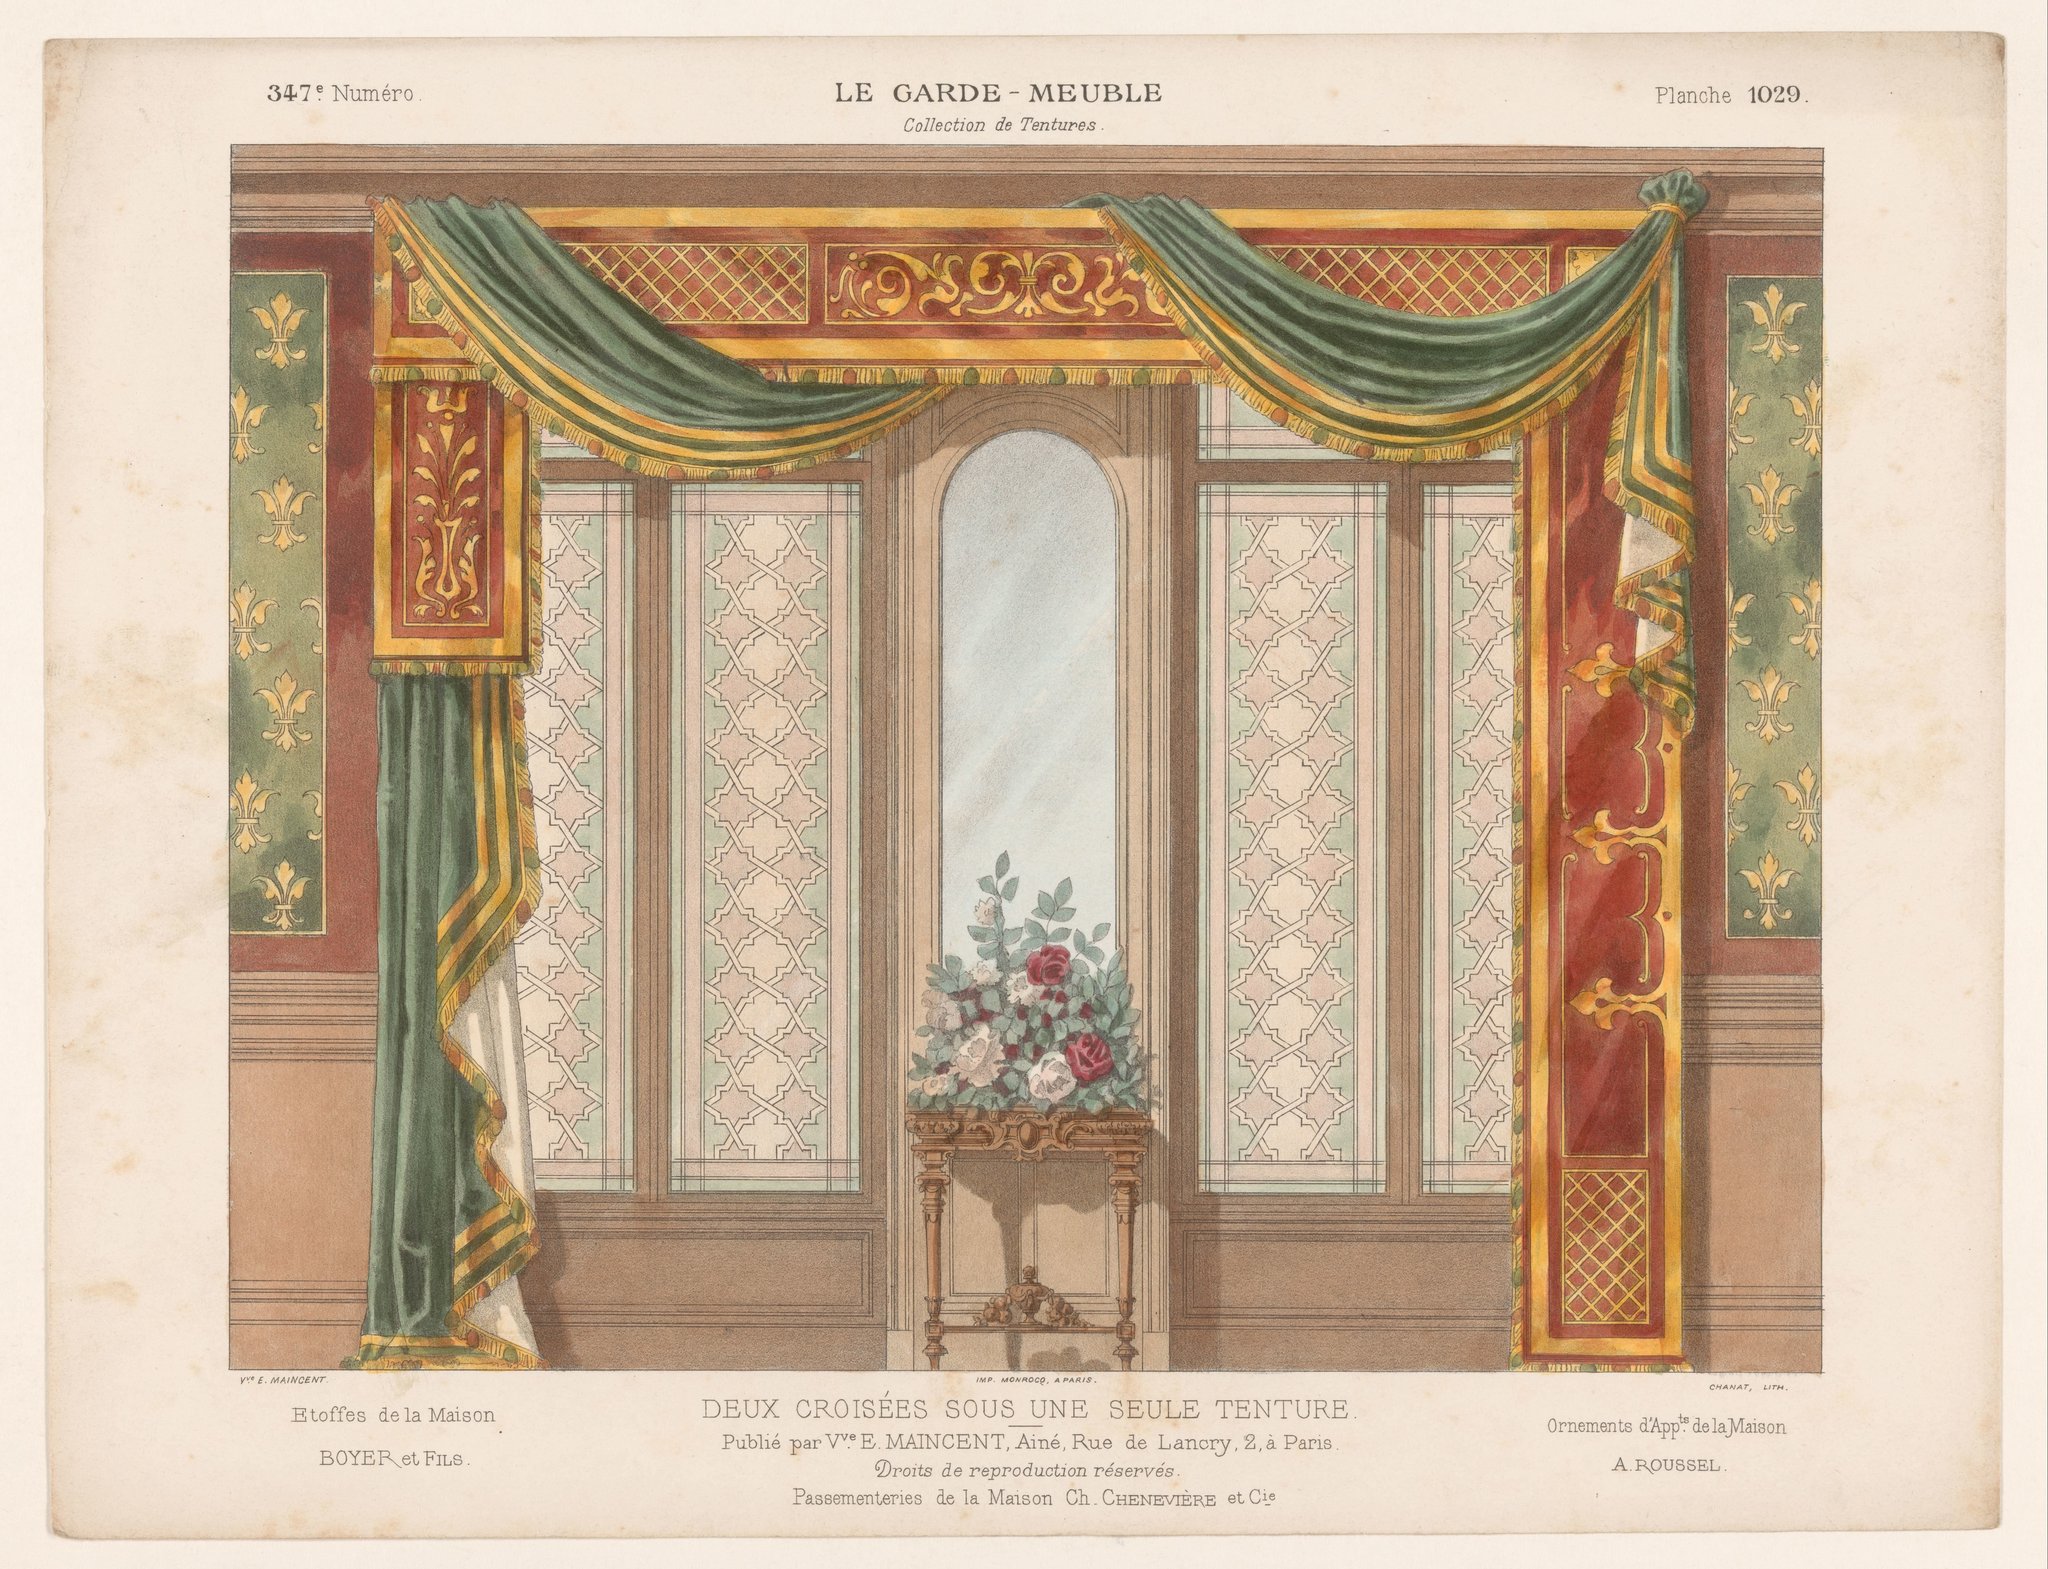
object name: print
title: Vensters met gordijn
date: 1895-1910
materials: paper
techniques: hand coloring, lithograph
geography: paris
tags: window, hangings and drapery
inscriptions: : ‘Droits de reproduction réservés.’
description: Twee kruisvensters met één gedrapeerd gordijn. Prent uit 347e Livraison.